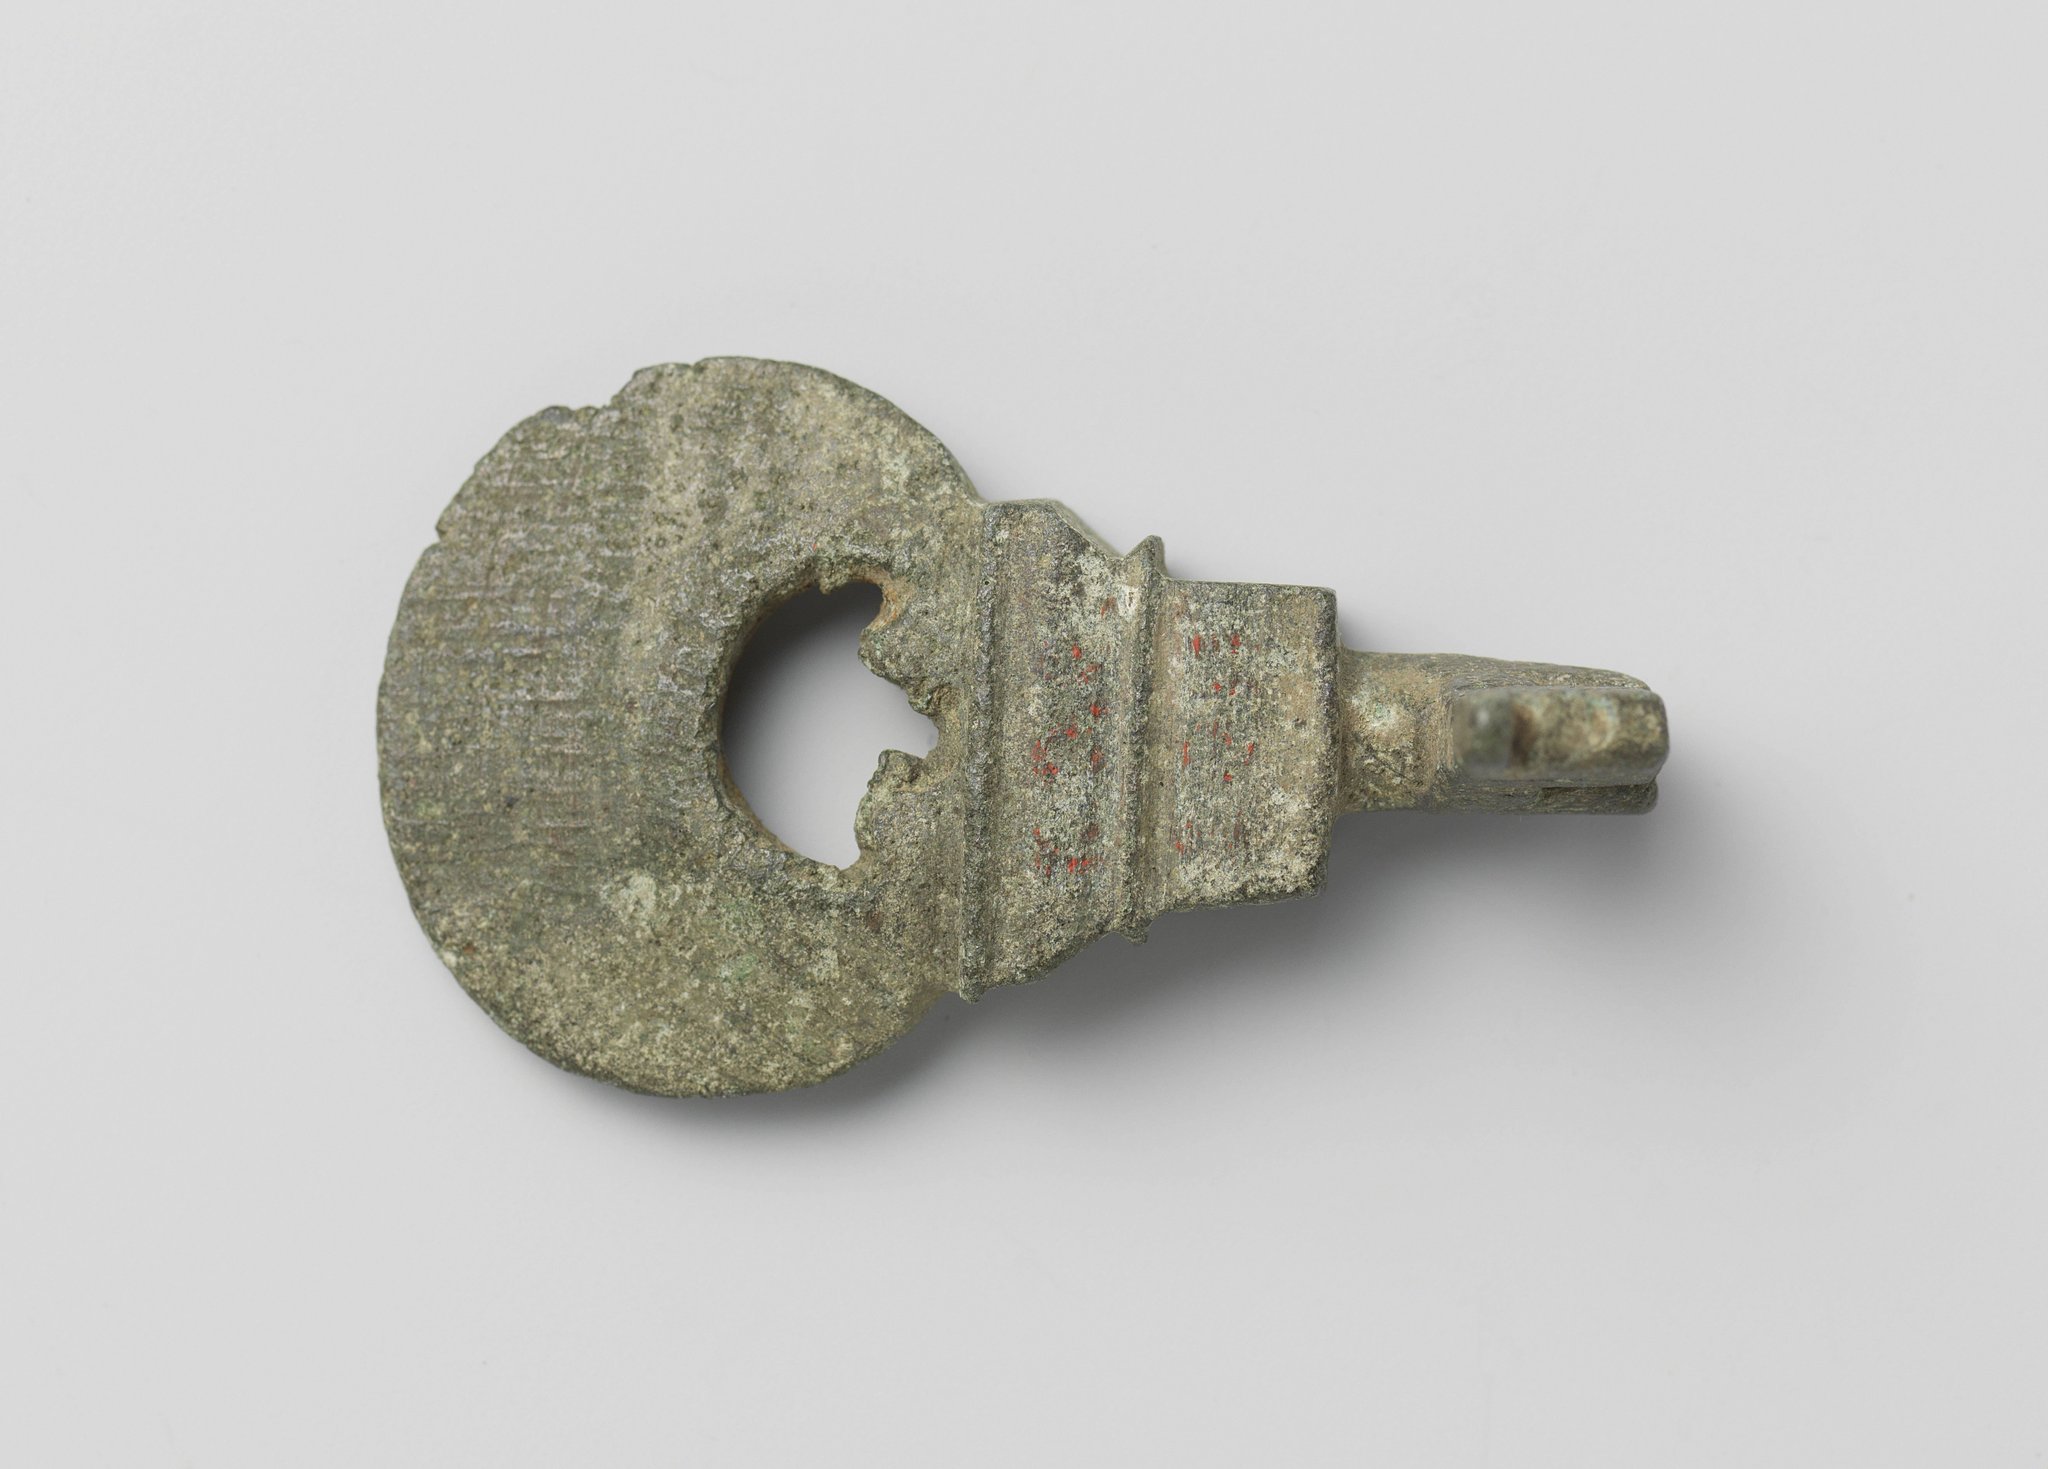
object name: pipe key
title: Key with barrel shank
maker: Anonymous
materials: bronze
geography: rome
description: Pijpsleutel met afgeplatte niervormige greep op vierhoekig en geprofileerd kapiteel. Baard en gedeelte van de schacht afgebroken.